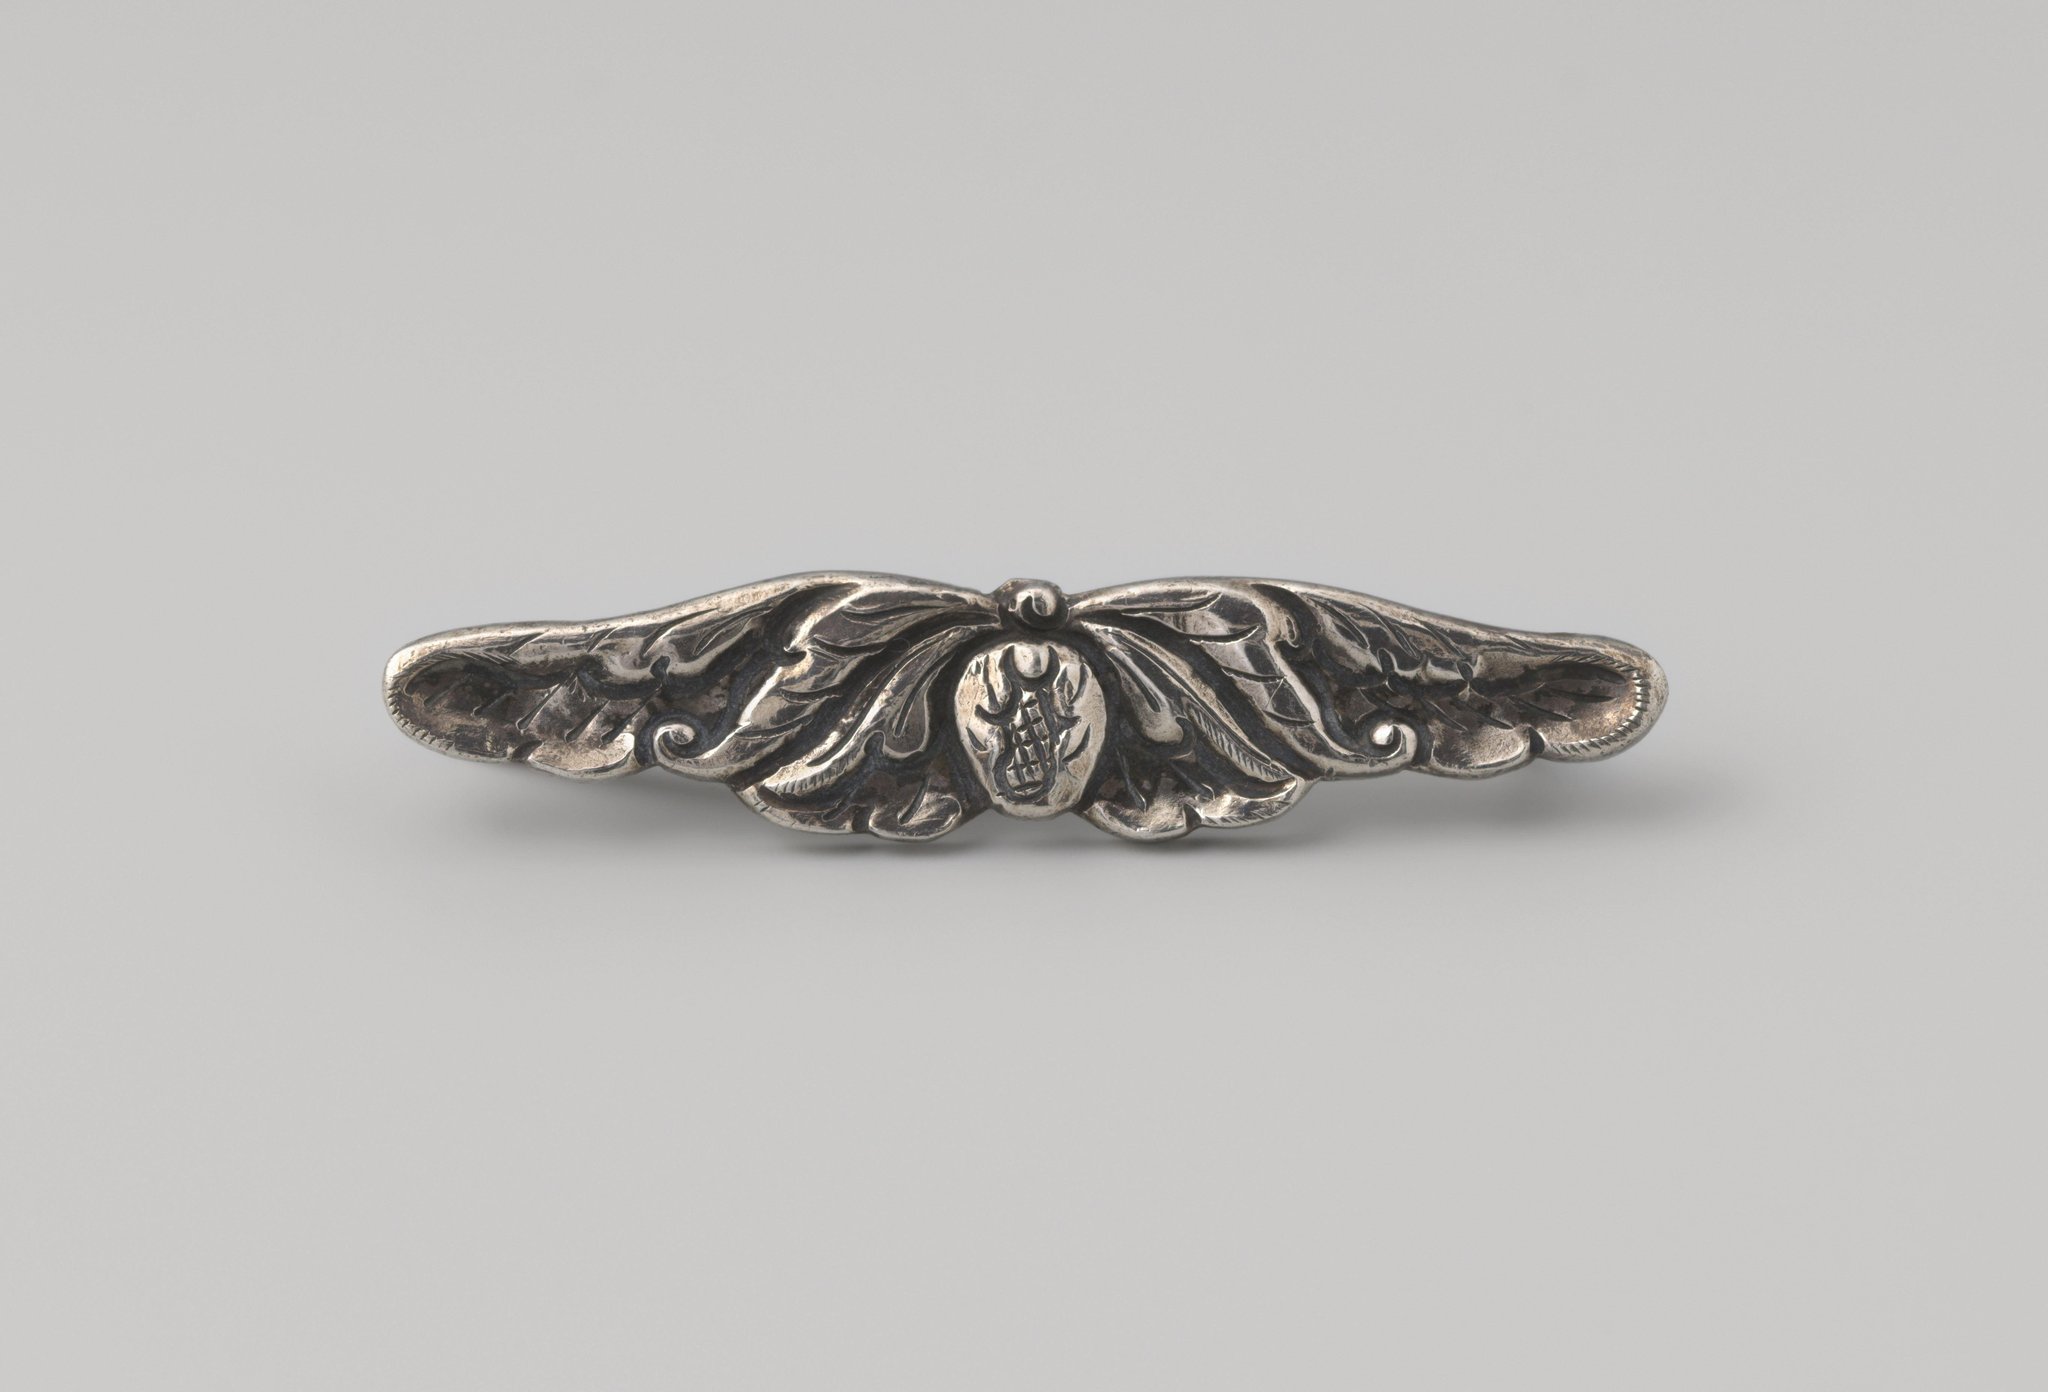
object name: tie tack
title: Dasklem van zilver met floraal reliëf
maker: Anonymous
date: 1940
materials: silver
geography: jogjakarta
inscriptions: maker's mark: ‘HS’, alloy mark: ‘800’